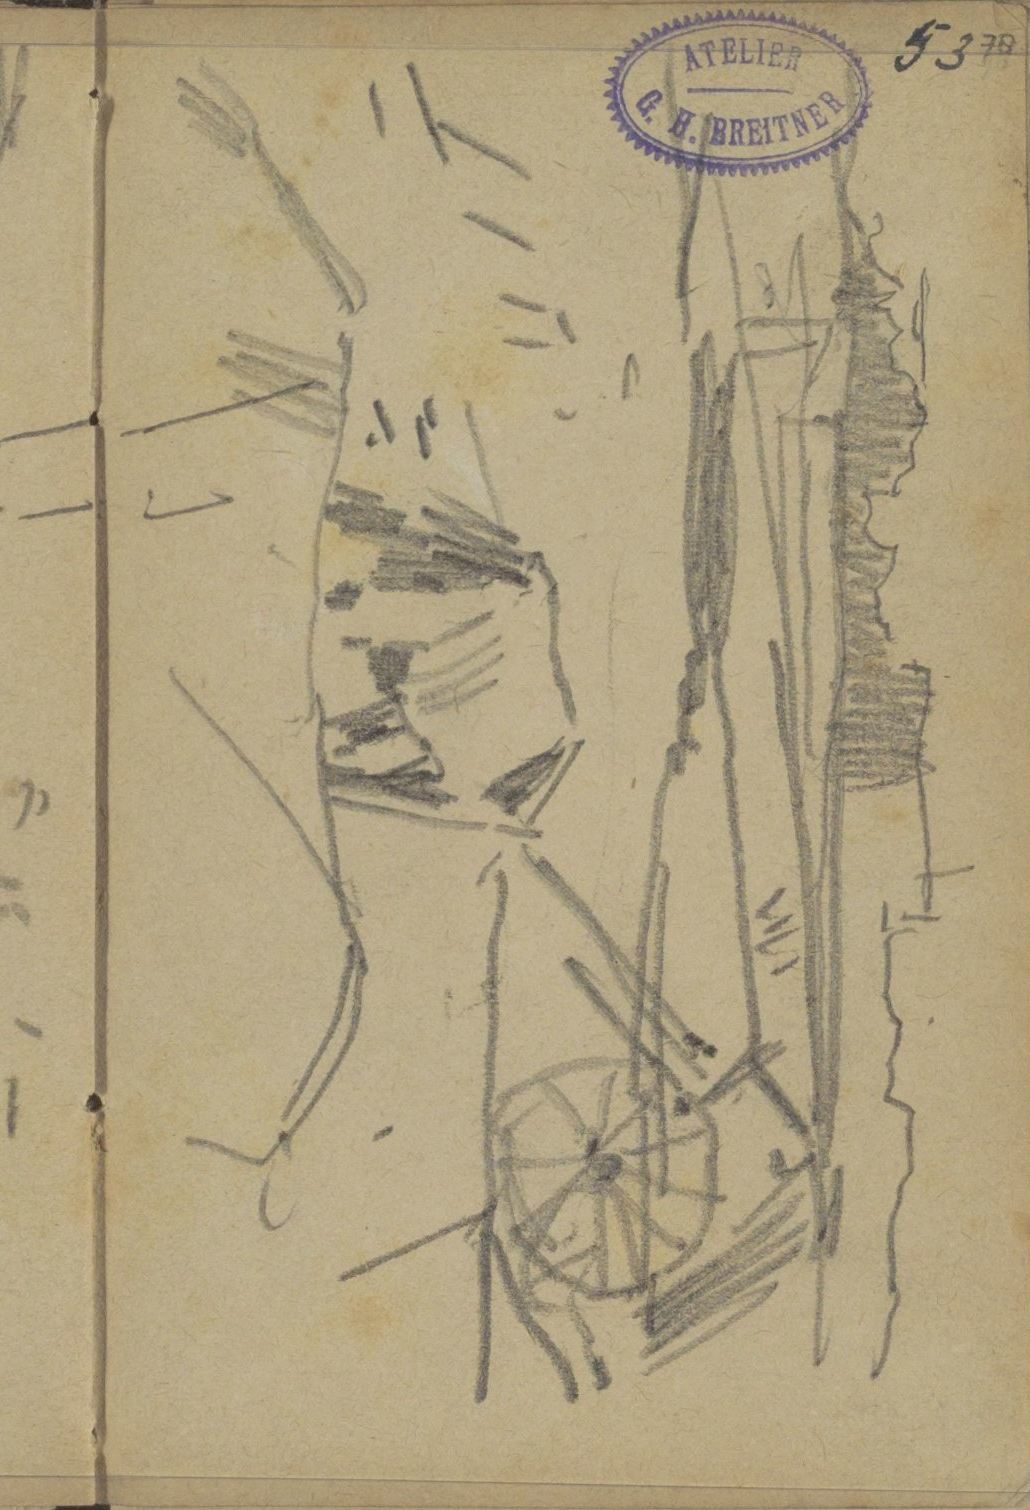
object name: sketchbook leaf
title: Kar in een landschap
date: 1887-1891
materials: paper, pencil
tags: landscapes, (farm) wagon, freight wagon, cart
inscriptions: workshop stamp: Lugt 291d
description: Pagina 78 uit een schetsboek met 83 bladen.